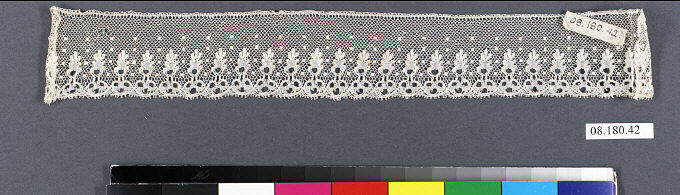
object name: piece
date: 1801-1833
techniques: lace